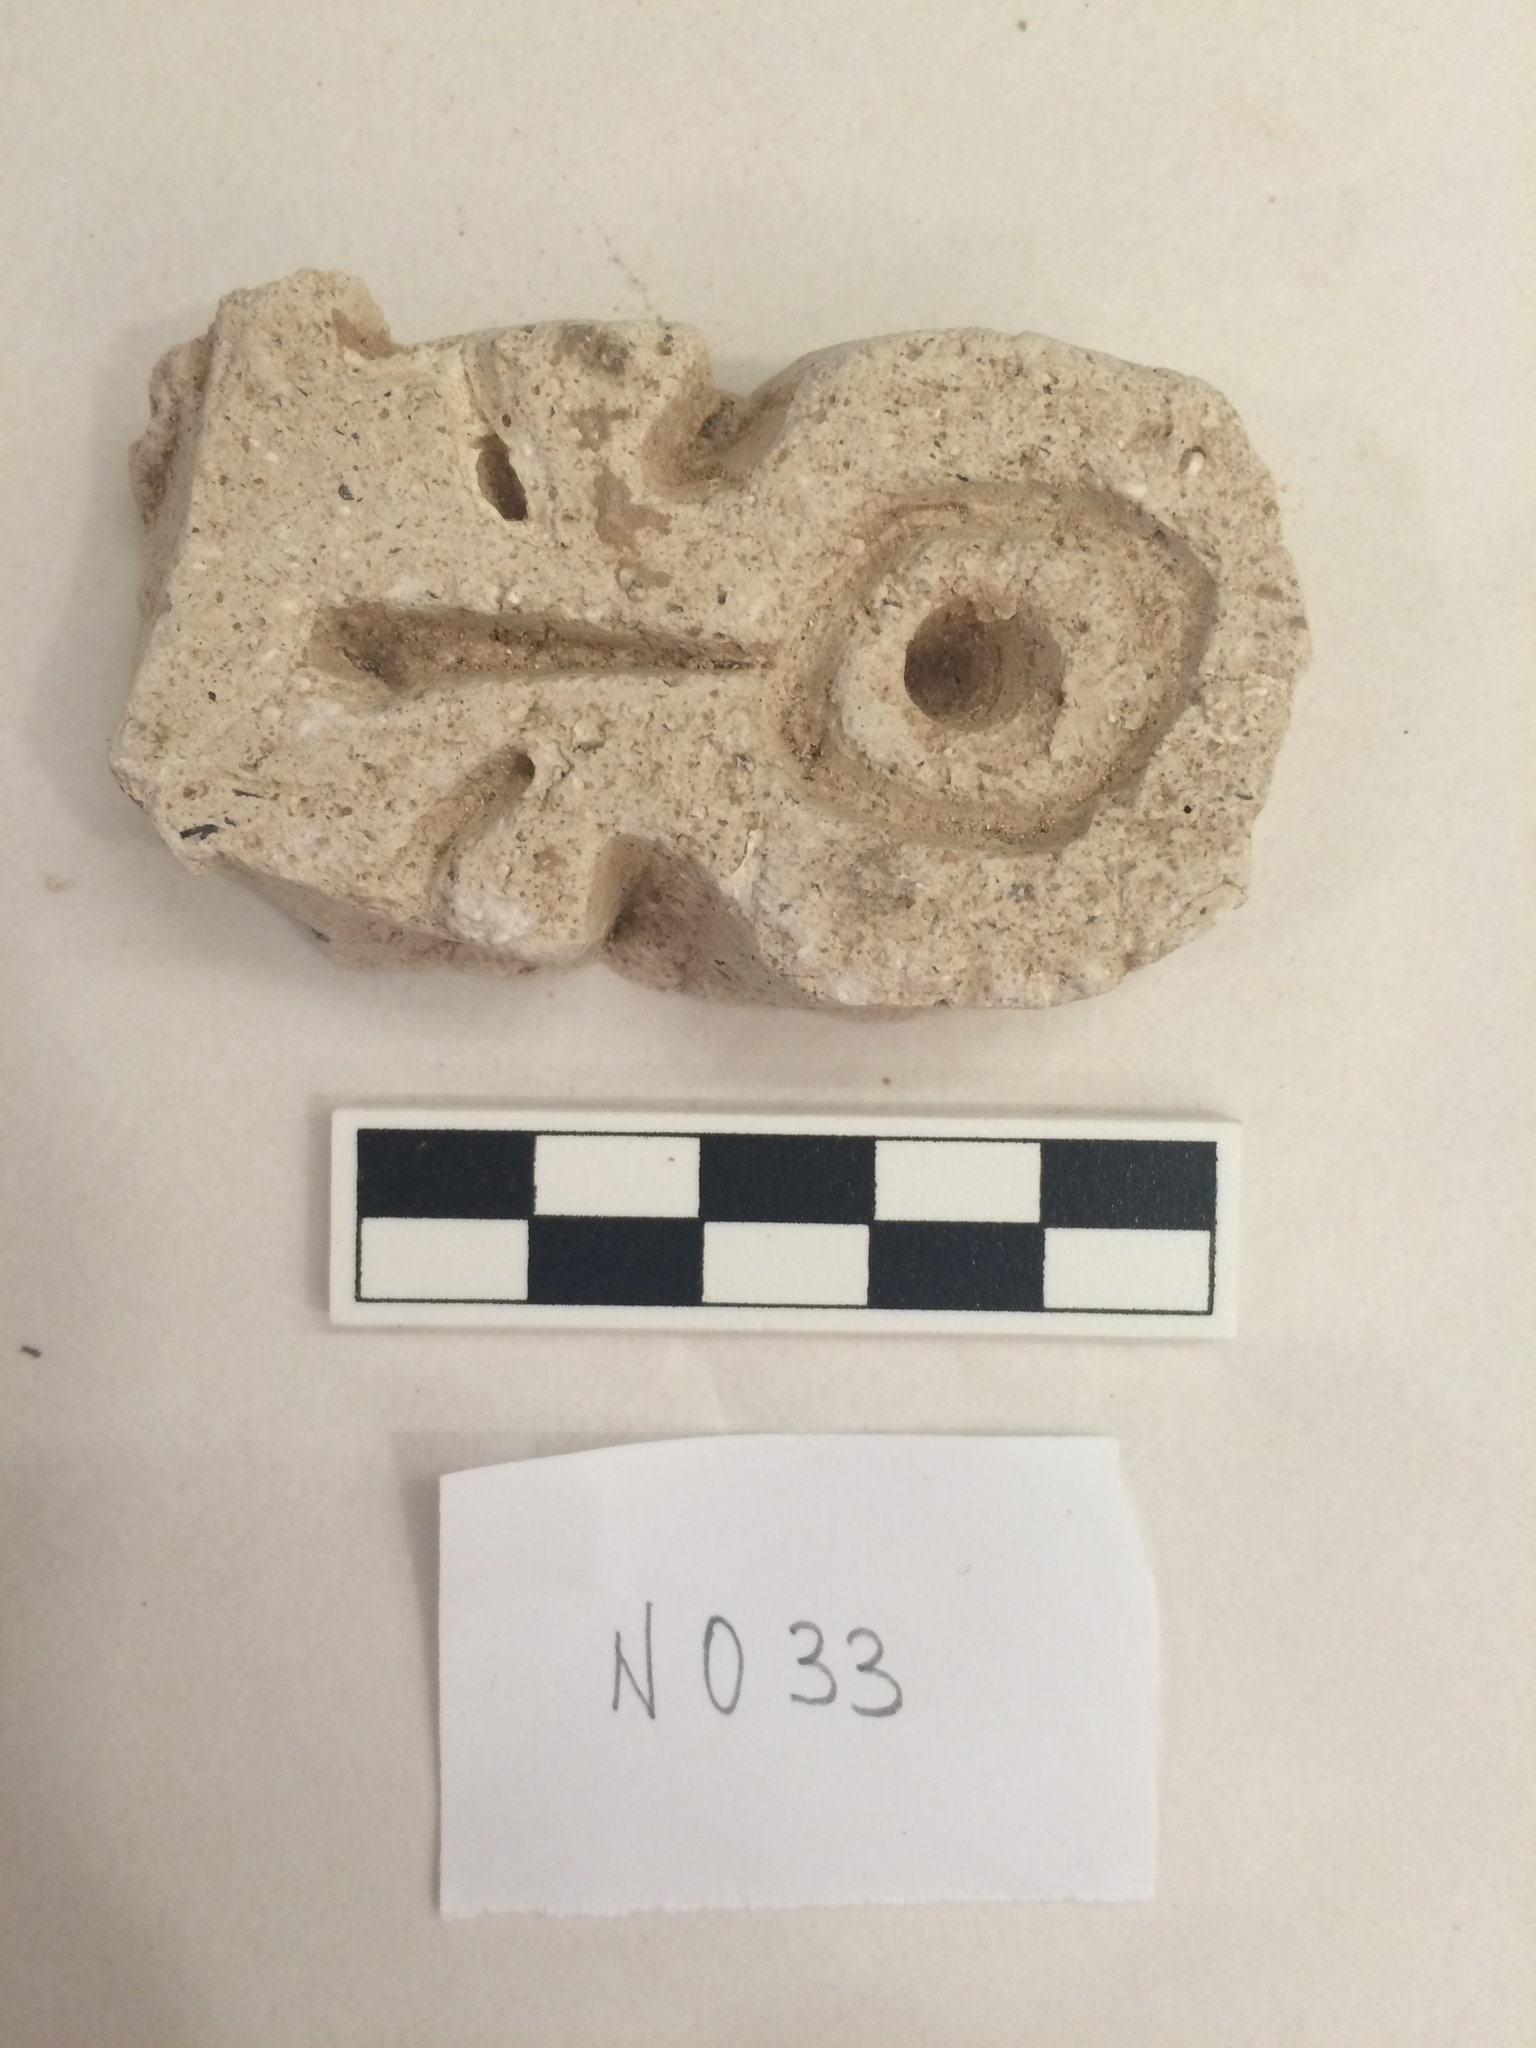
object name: fragment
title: Stucco Fragment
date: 701-1200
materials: plaster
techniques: carving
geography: iran